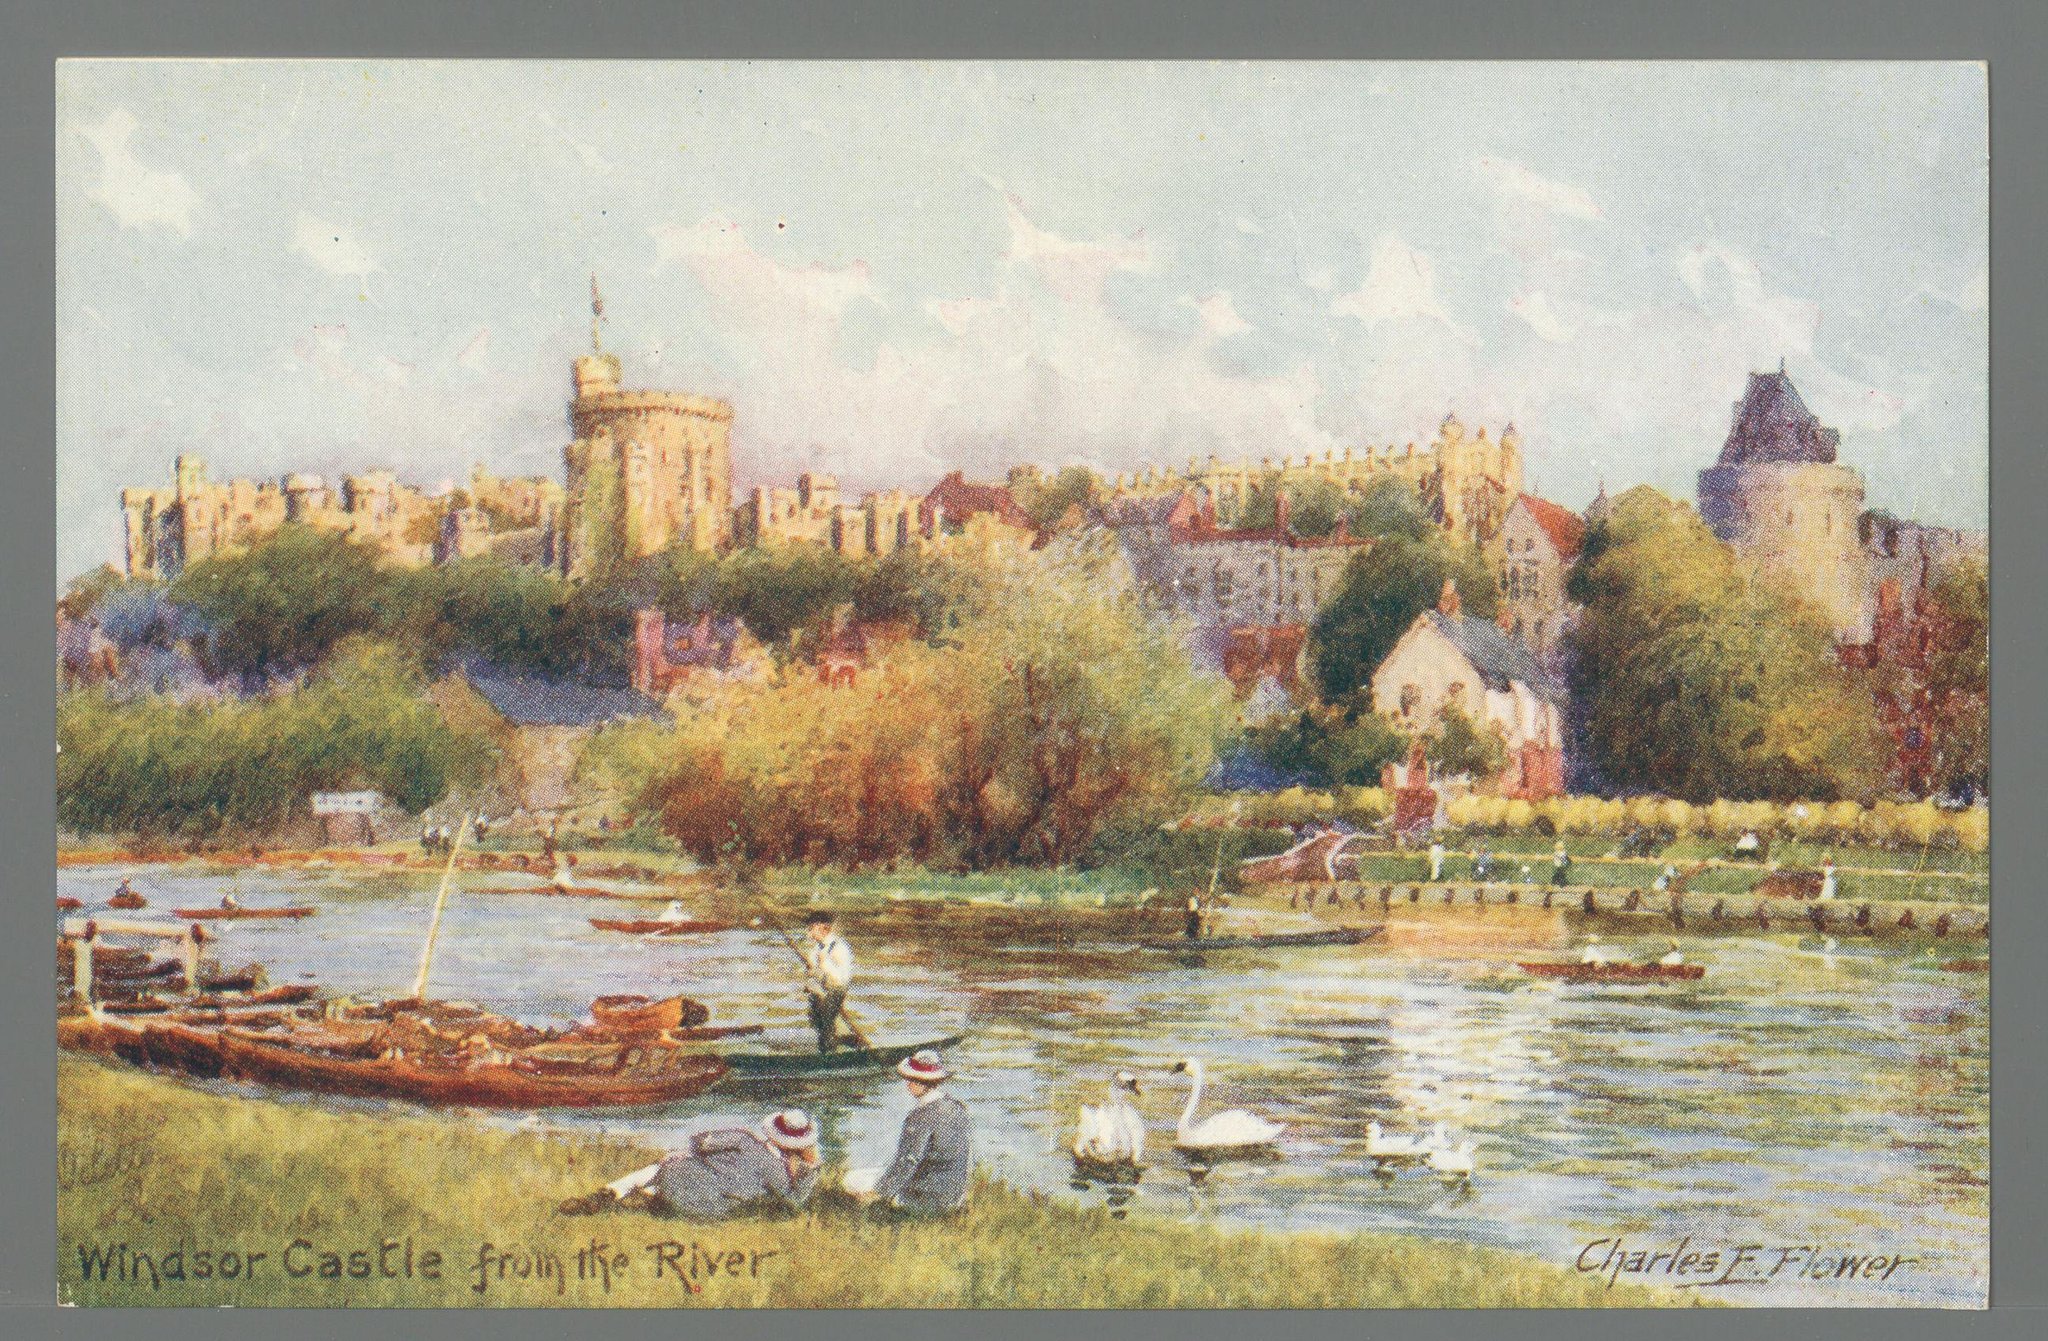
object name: ansichtkaart, prentbriefkaart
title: Oilette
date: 1904-1912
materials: cardboard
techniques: color autotype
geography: london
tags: castle, canals, waters (in city), thames